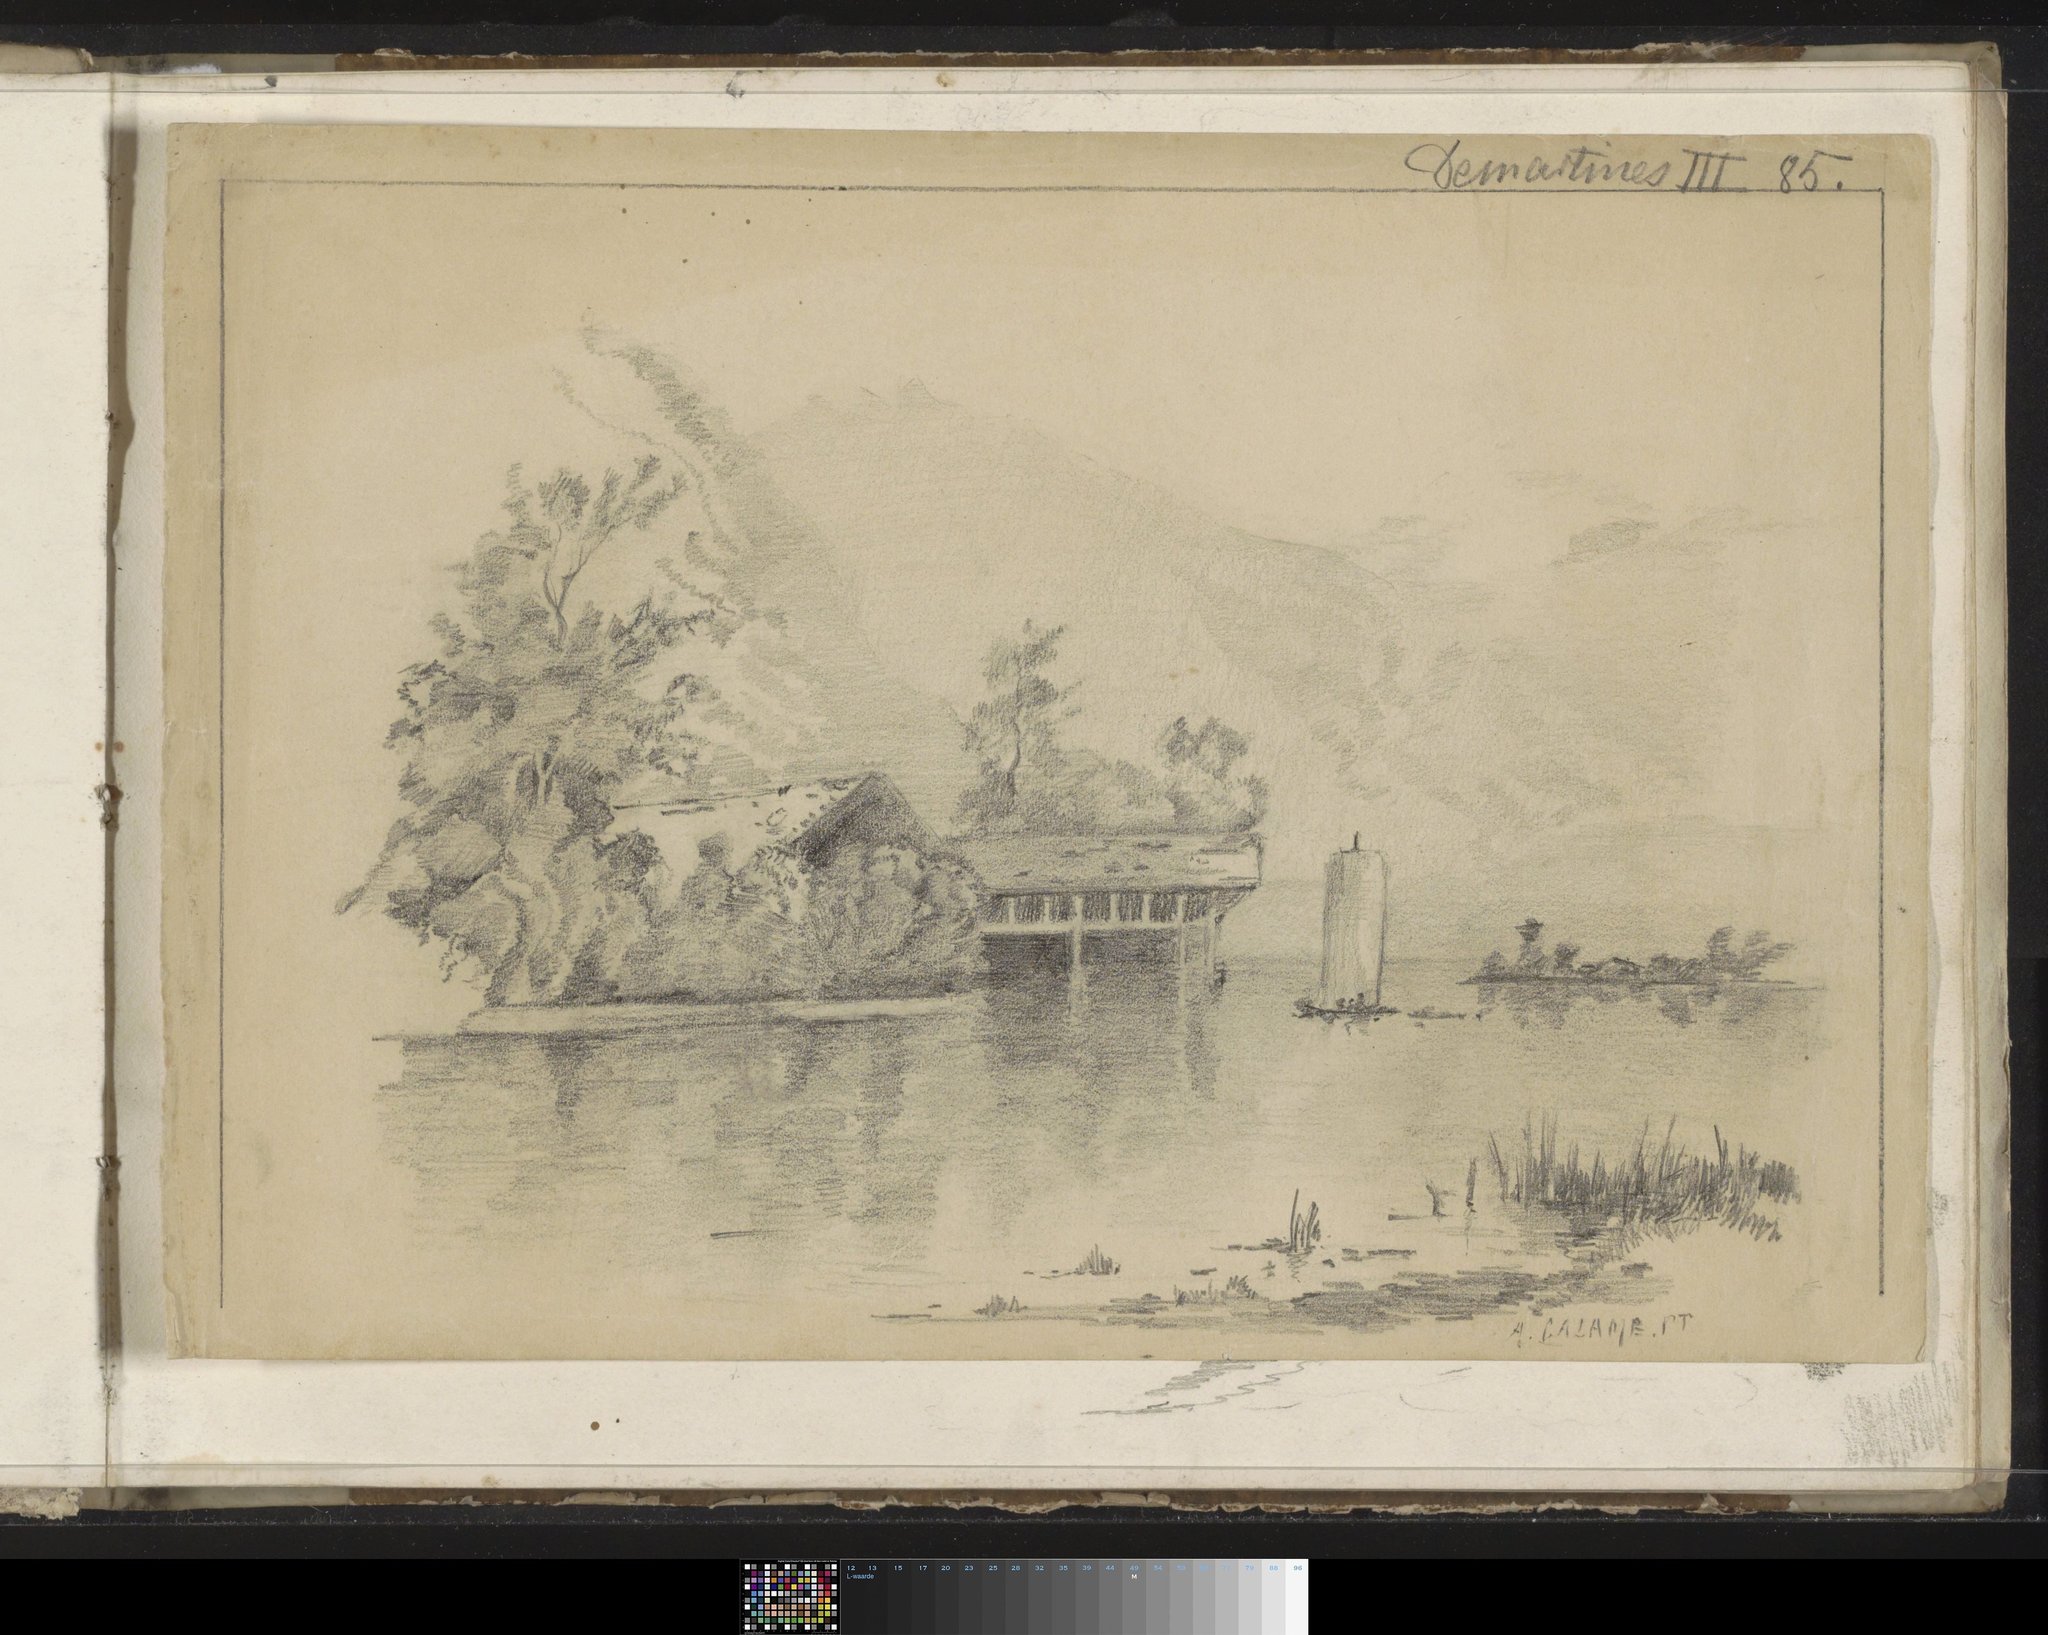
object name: sketchbook leaf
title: Meer in een berglandschap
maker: maria vos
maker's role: draughtsman, painter, print maker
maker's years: 1824-1906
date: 1834-1906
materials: paper, pencil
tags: landscapes with waters, waterscapes, seascapes (in the temperate zone), mountains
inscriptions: annotation: ‘Demartines III 85/ A. CALAME PT’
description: Losse tekening tussen het voorste schutblad en pagina 1 van een schetsboek met 39 bladen.